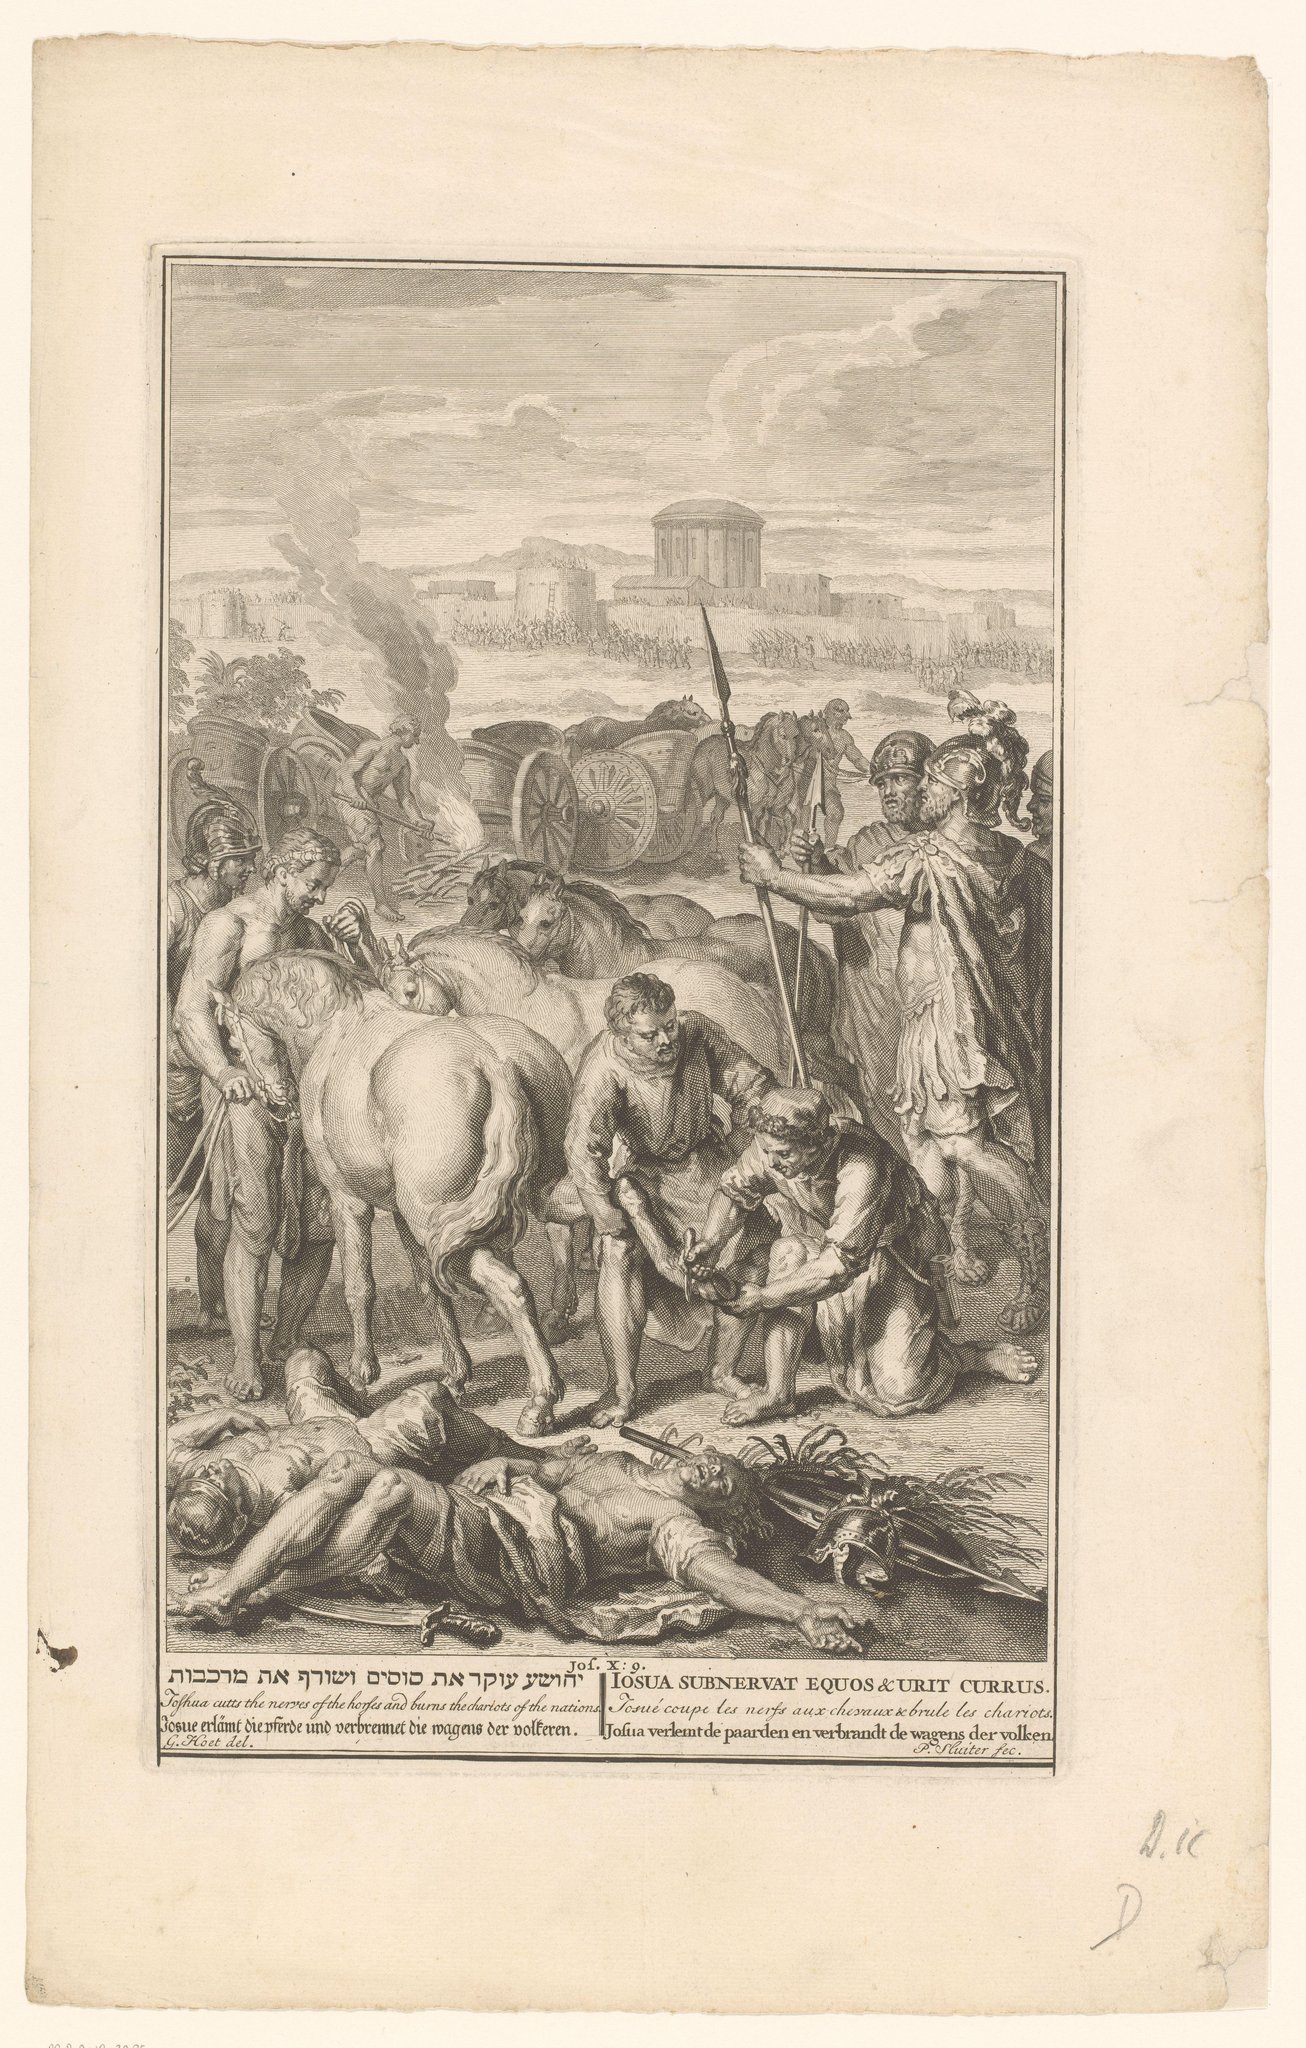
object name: print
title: Jozua verlamt de paarden en verbrandt de wagens der volken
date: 1720-1728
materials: paper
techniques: engraving, etching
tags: the kings of the north are defeated by joshua, who burns their chariots and cripples their horses by cutting the hamstrings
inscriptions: inscription: ‘ütrechts Fündatie hüijs’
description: Prent gemaakt voor: Figures de la Bible. Amsterdam: Bernard Picart, 1720. Prent ook gebruikt in: Taferelen der voornaamste geschiedenissen van het Oude en Nieuwe Testament (...) door de vermaarde kunstenaars Hoet, Houbraken, en Picart getekent (...) en met beschrijvingen uitgebreid. Den Haag: Pieter de Hondt, 1728.